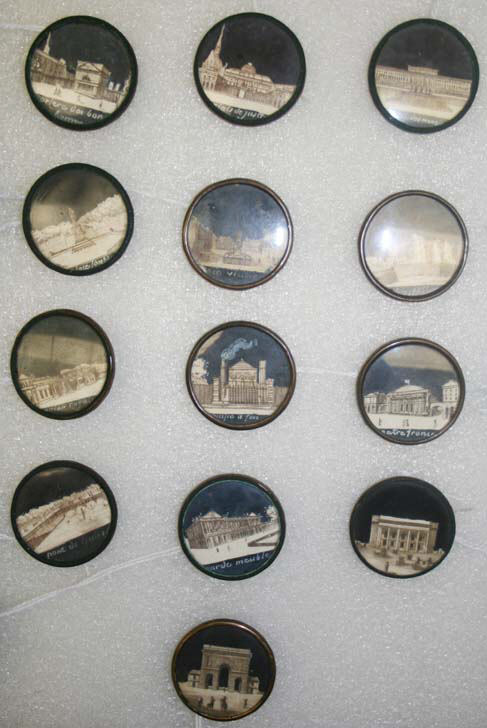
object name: button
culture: french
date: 1780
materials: watercolor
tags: buildings